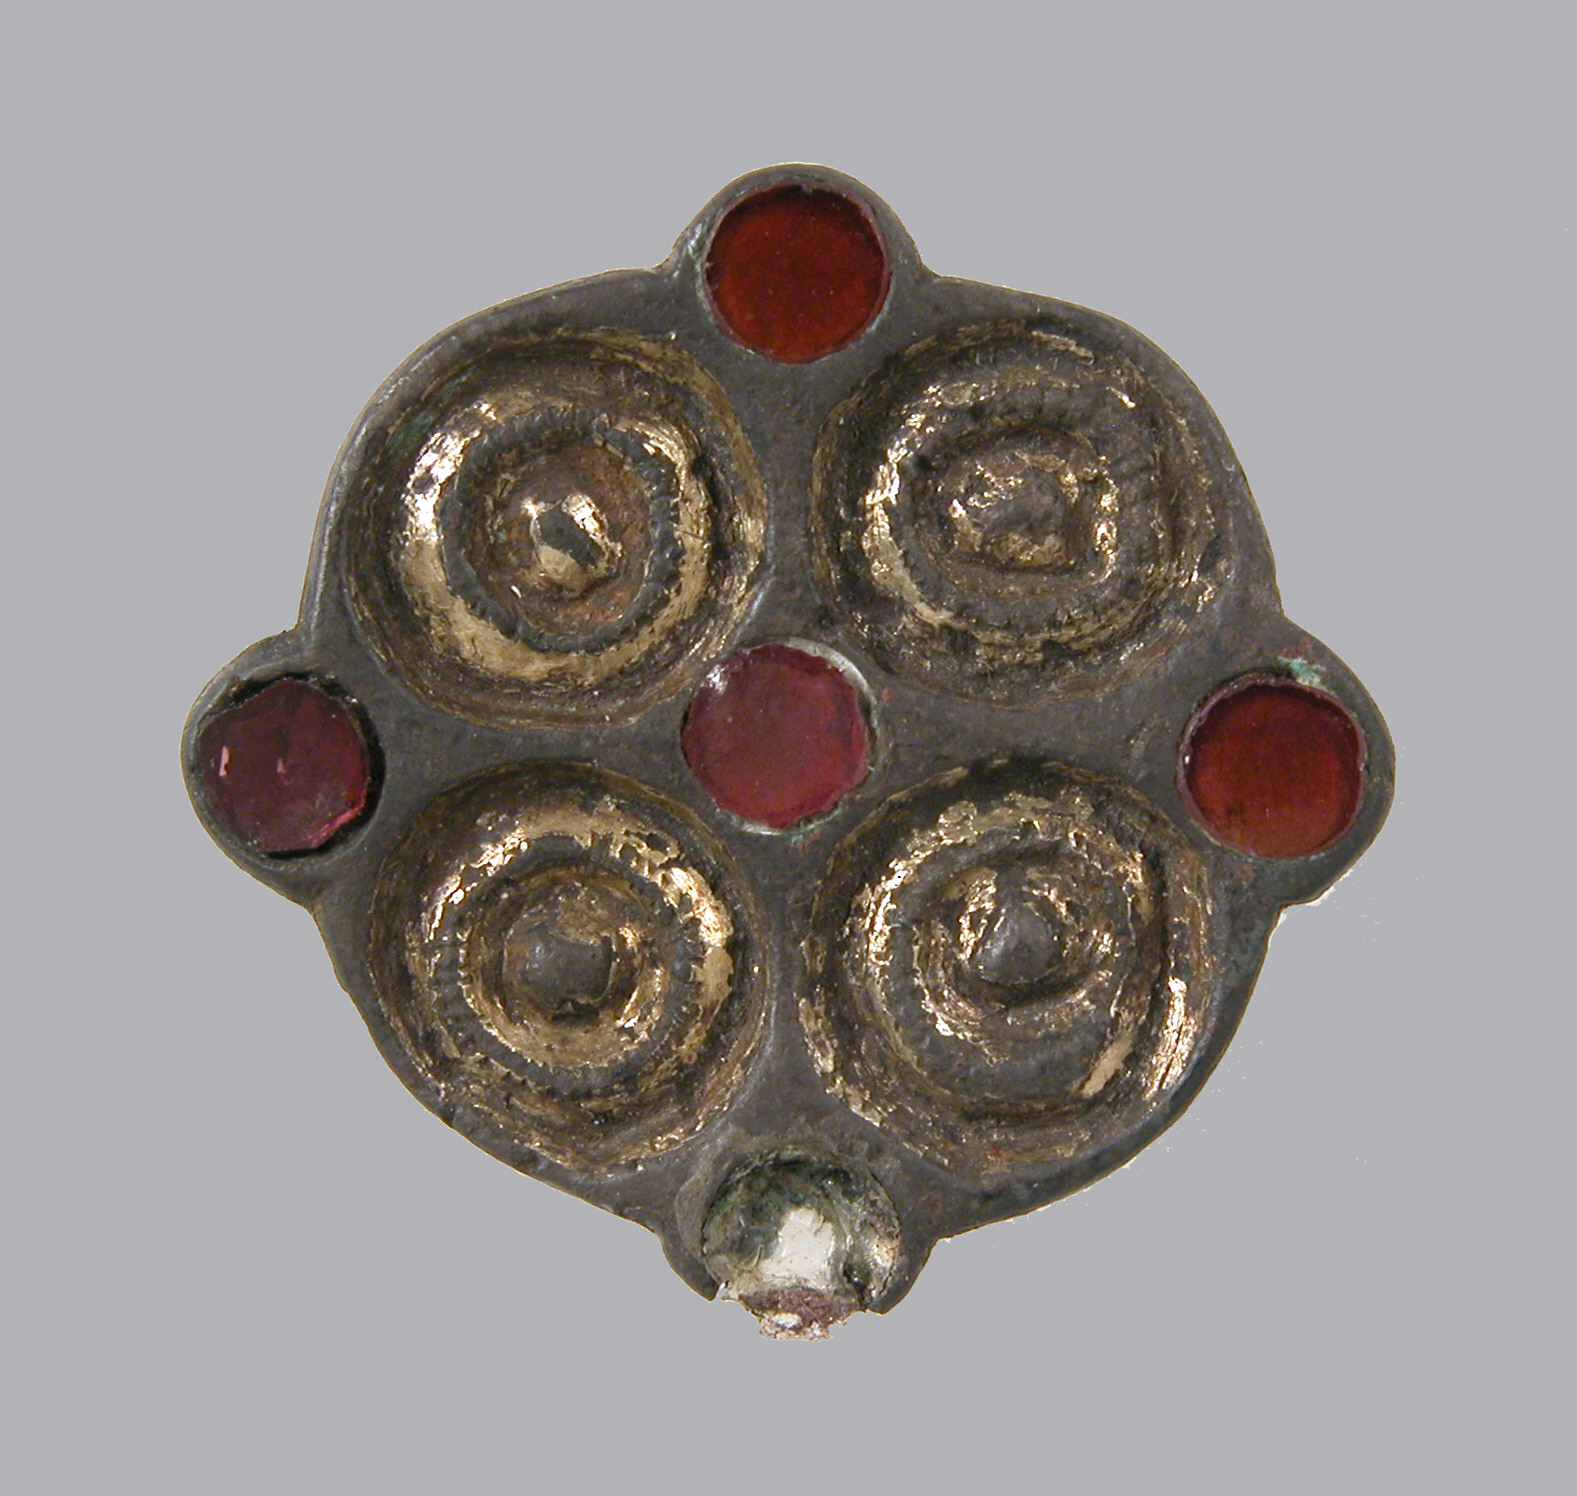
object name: brooch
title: Whorl-Shaped Brooch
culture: frankish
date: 501-600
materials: glass, paste, silver gilt